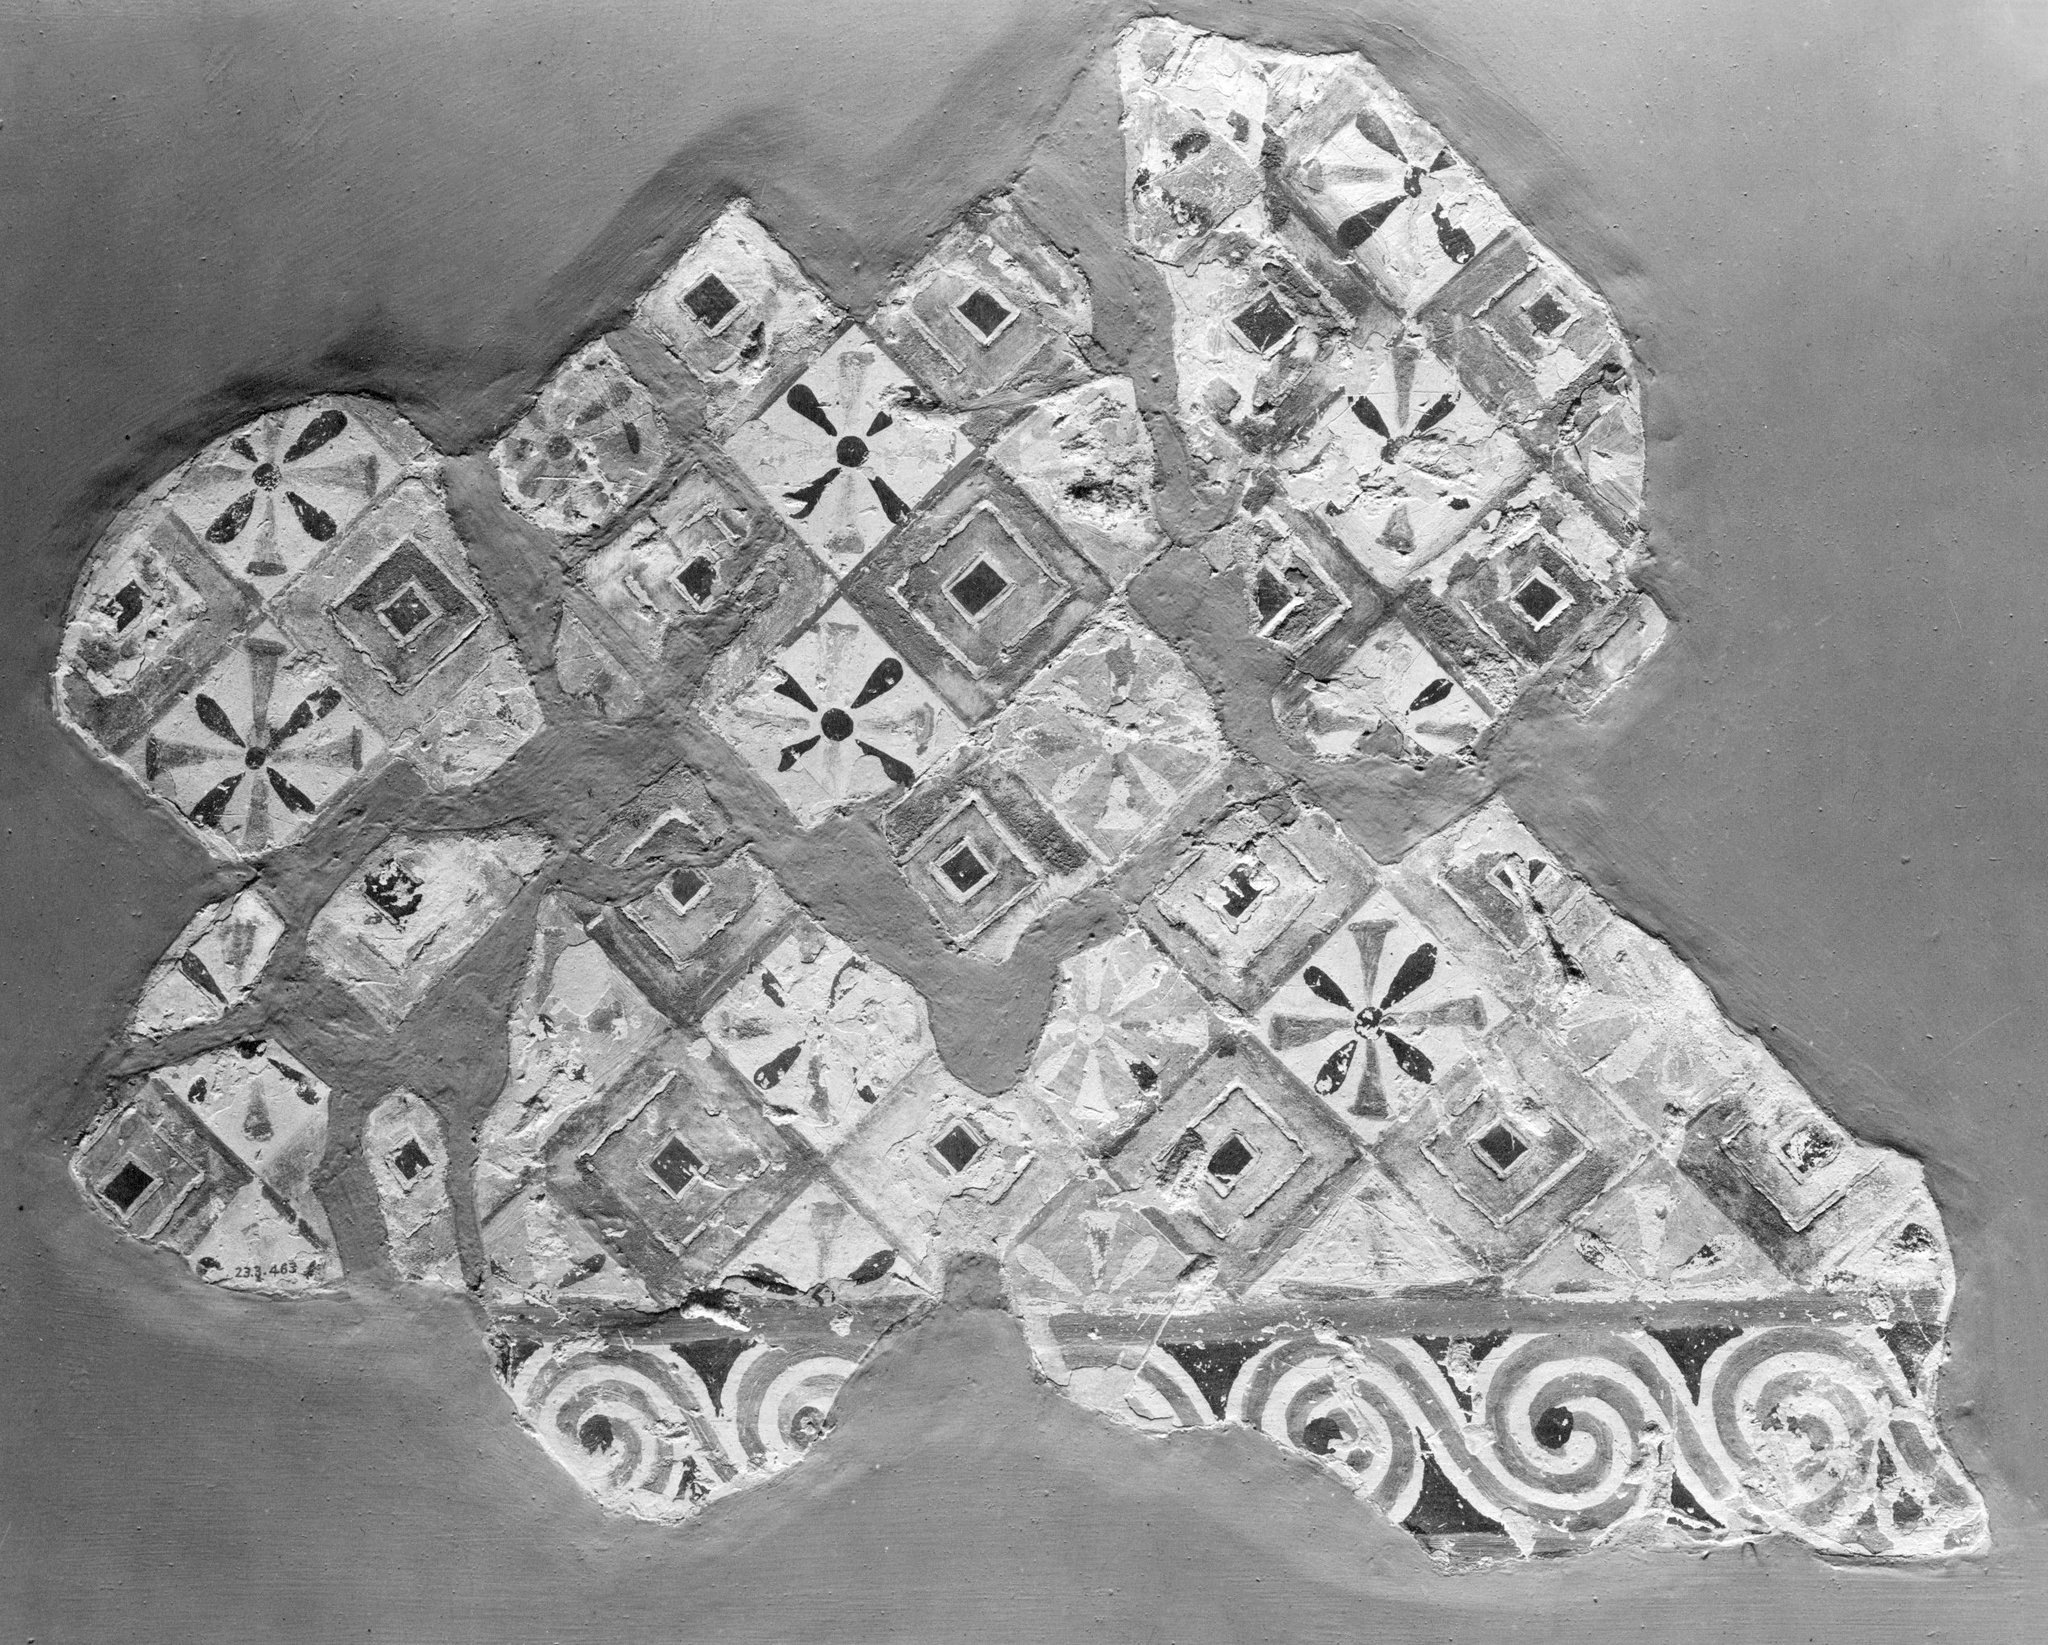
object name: ceiling painting, senenmut, tt 71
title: Ceiling Painting from the Tomb Chapel of Senenmut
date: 1479-1458 BCE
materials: mud, paint, plaster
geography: egypt